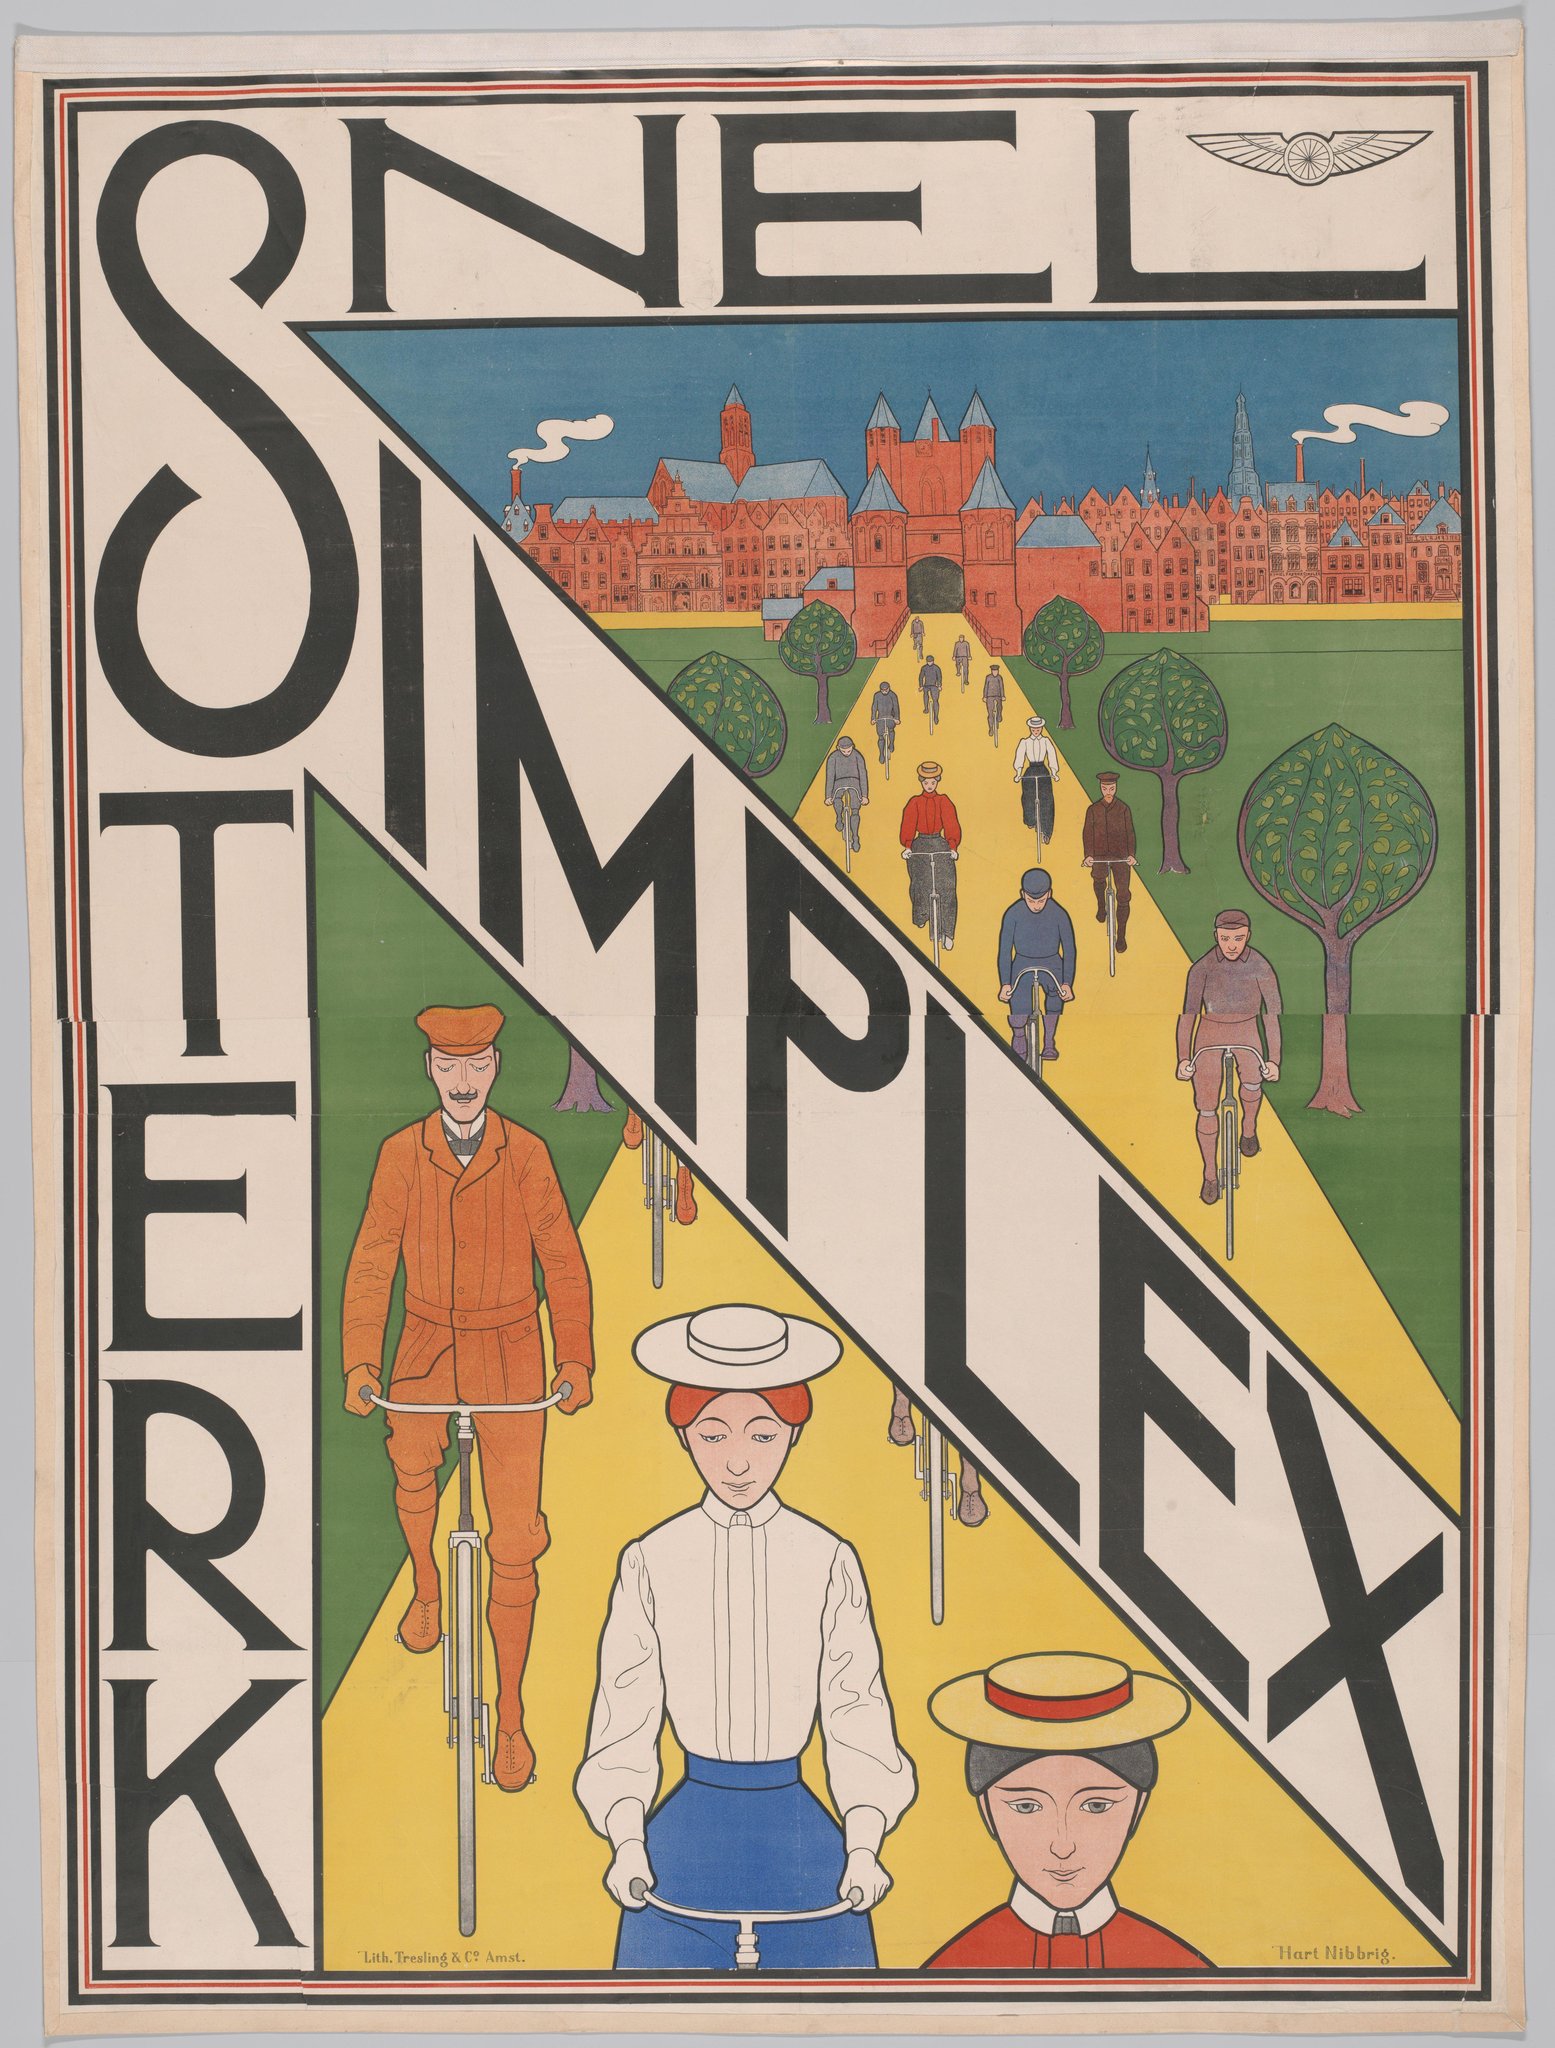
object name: poster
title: Simplex Snel Sterk (Simplex Speedy [and] Strong)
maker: ferdinand hart nibbrig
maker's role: draughtsman, painter, print maker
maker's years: 1866-1915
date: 1897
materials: paper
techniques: lithograph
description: This poster evokes the image of ‘getting out and about.’ Cycling was considered a healthy leisure activity from around 1900. Two ladies lead a procession riding away from town. The bicycle afforded women freedom of movement and became a symbol of women’s emancipation. Bicycle factory Simplex was based in Amsterdam from 1896 and used a simple advertising slogan: Simplex Snel Sterk (Simplex Speedy [and] Strong).